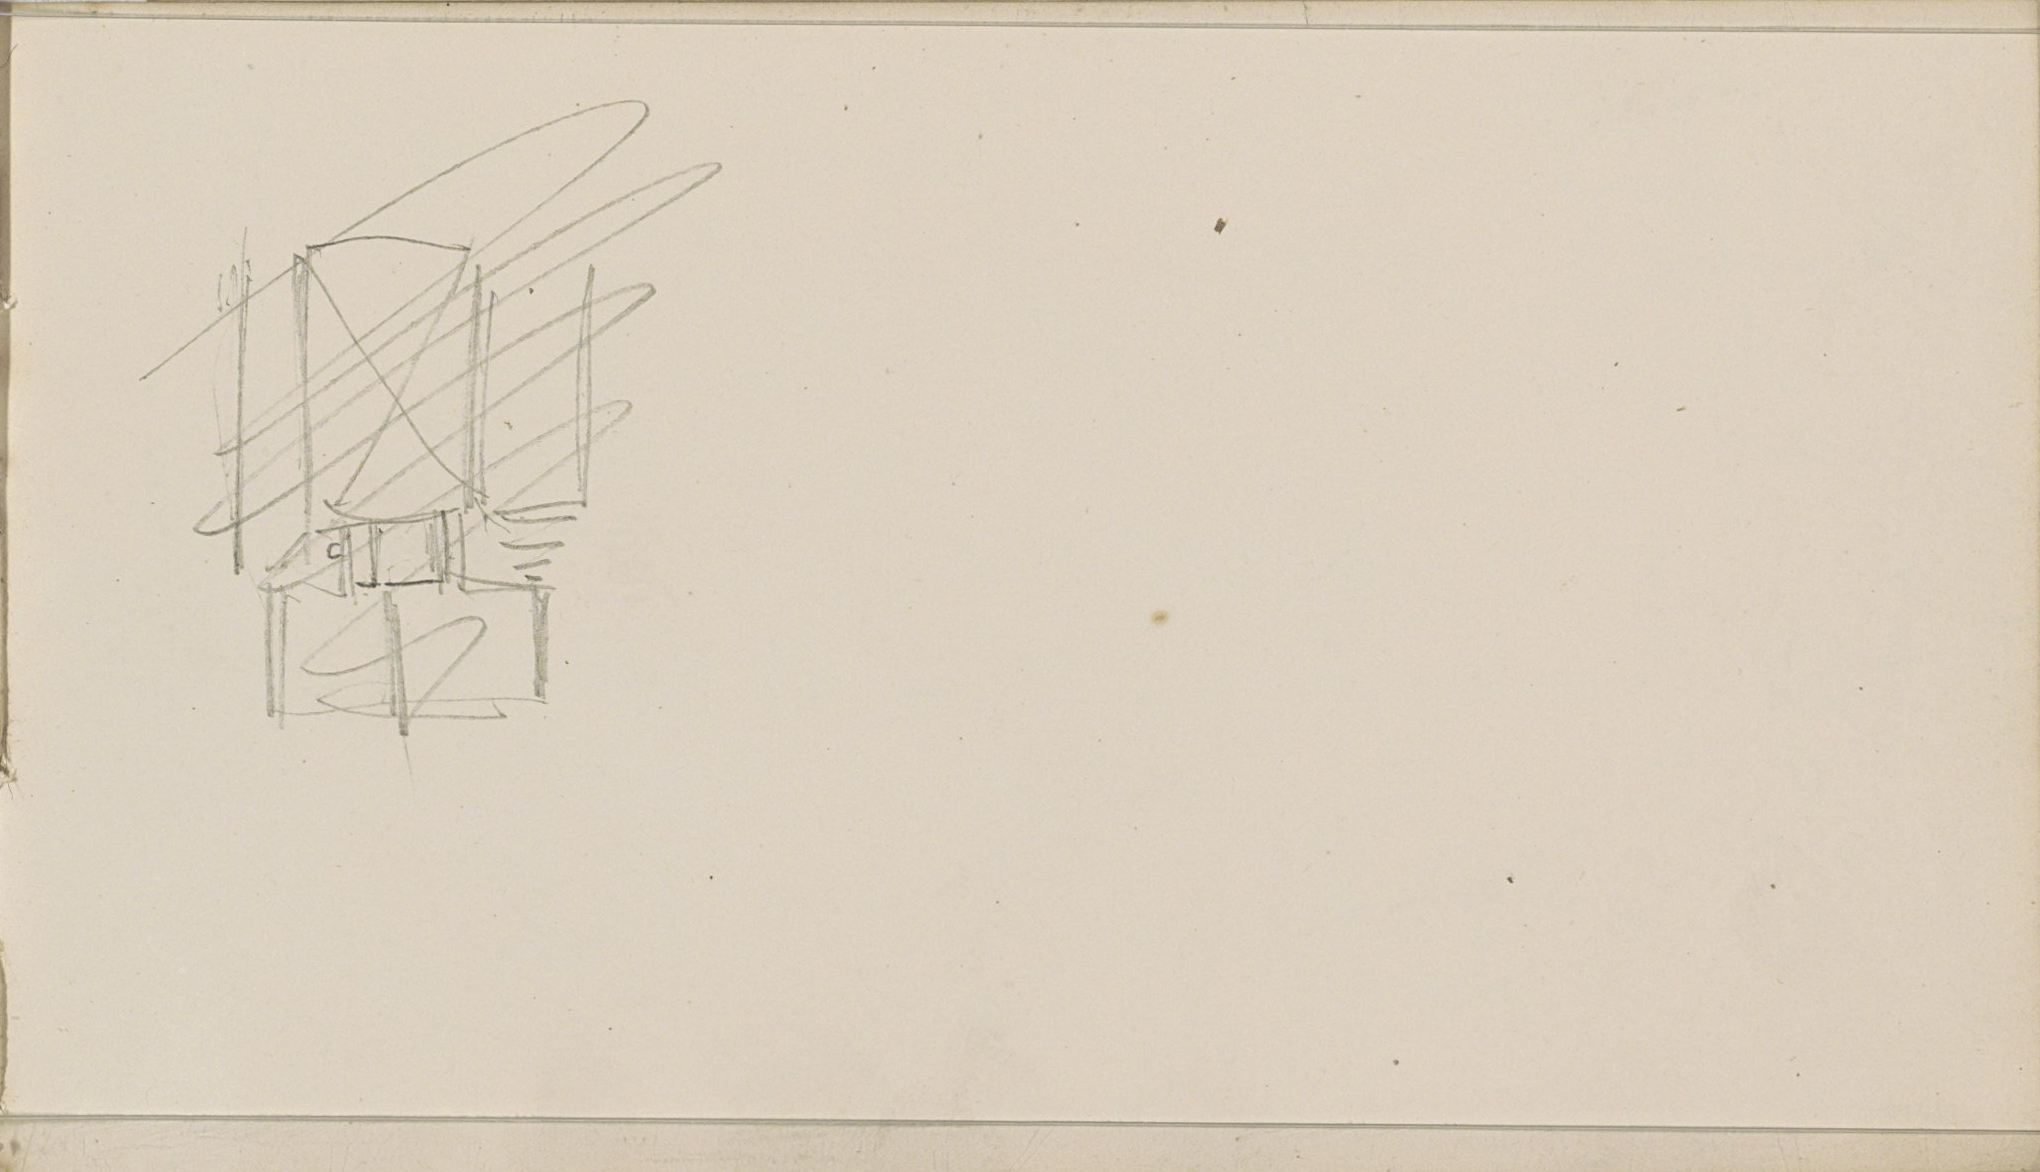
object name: sketchbook leaf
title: Architectuurstudie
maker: isaac gosschalk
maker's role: draughtsman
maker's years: 1838-1907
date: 1866-1868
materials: paper, pencil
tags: architecture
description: Blad 19 recto uit een schetsboek met 67 bladen.